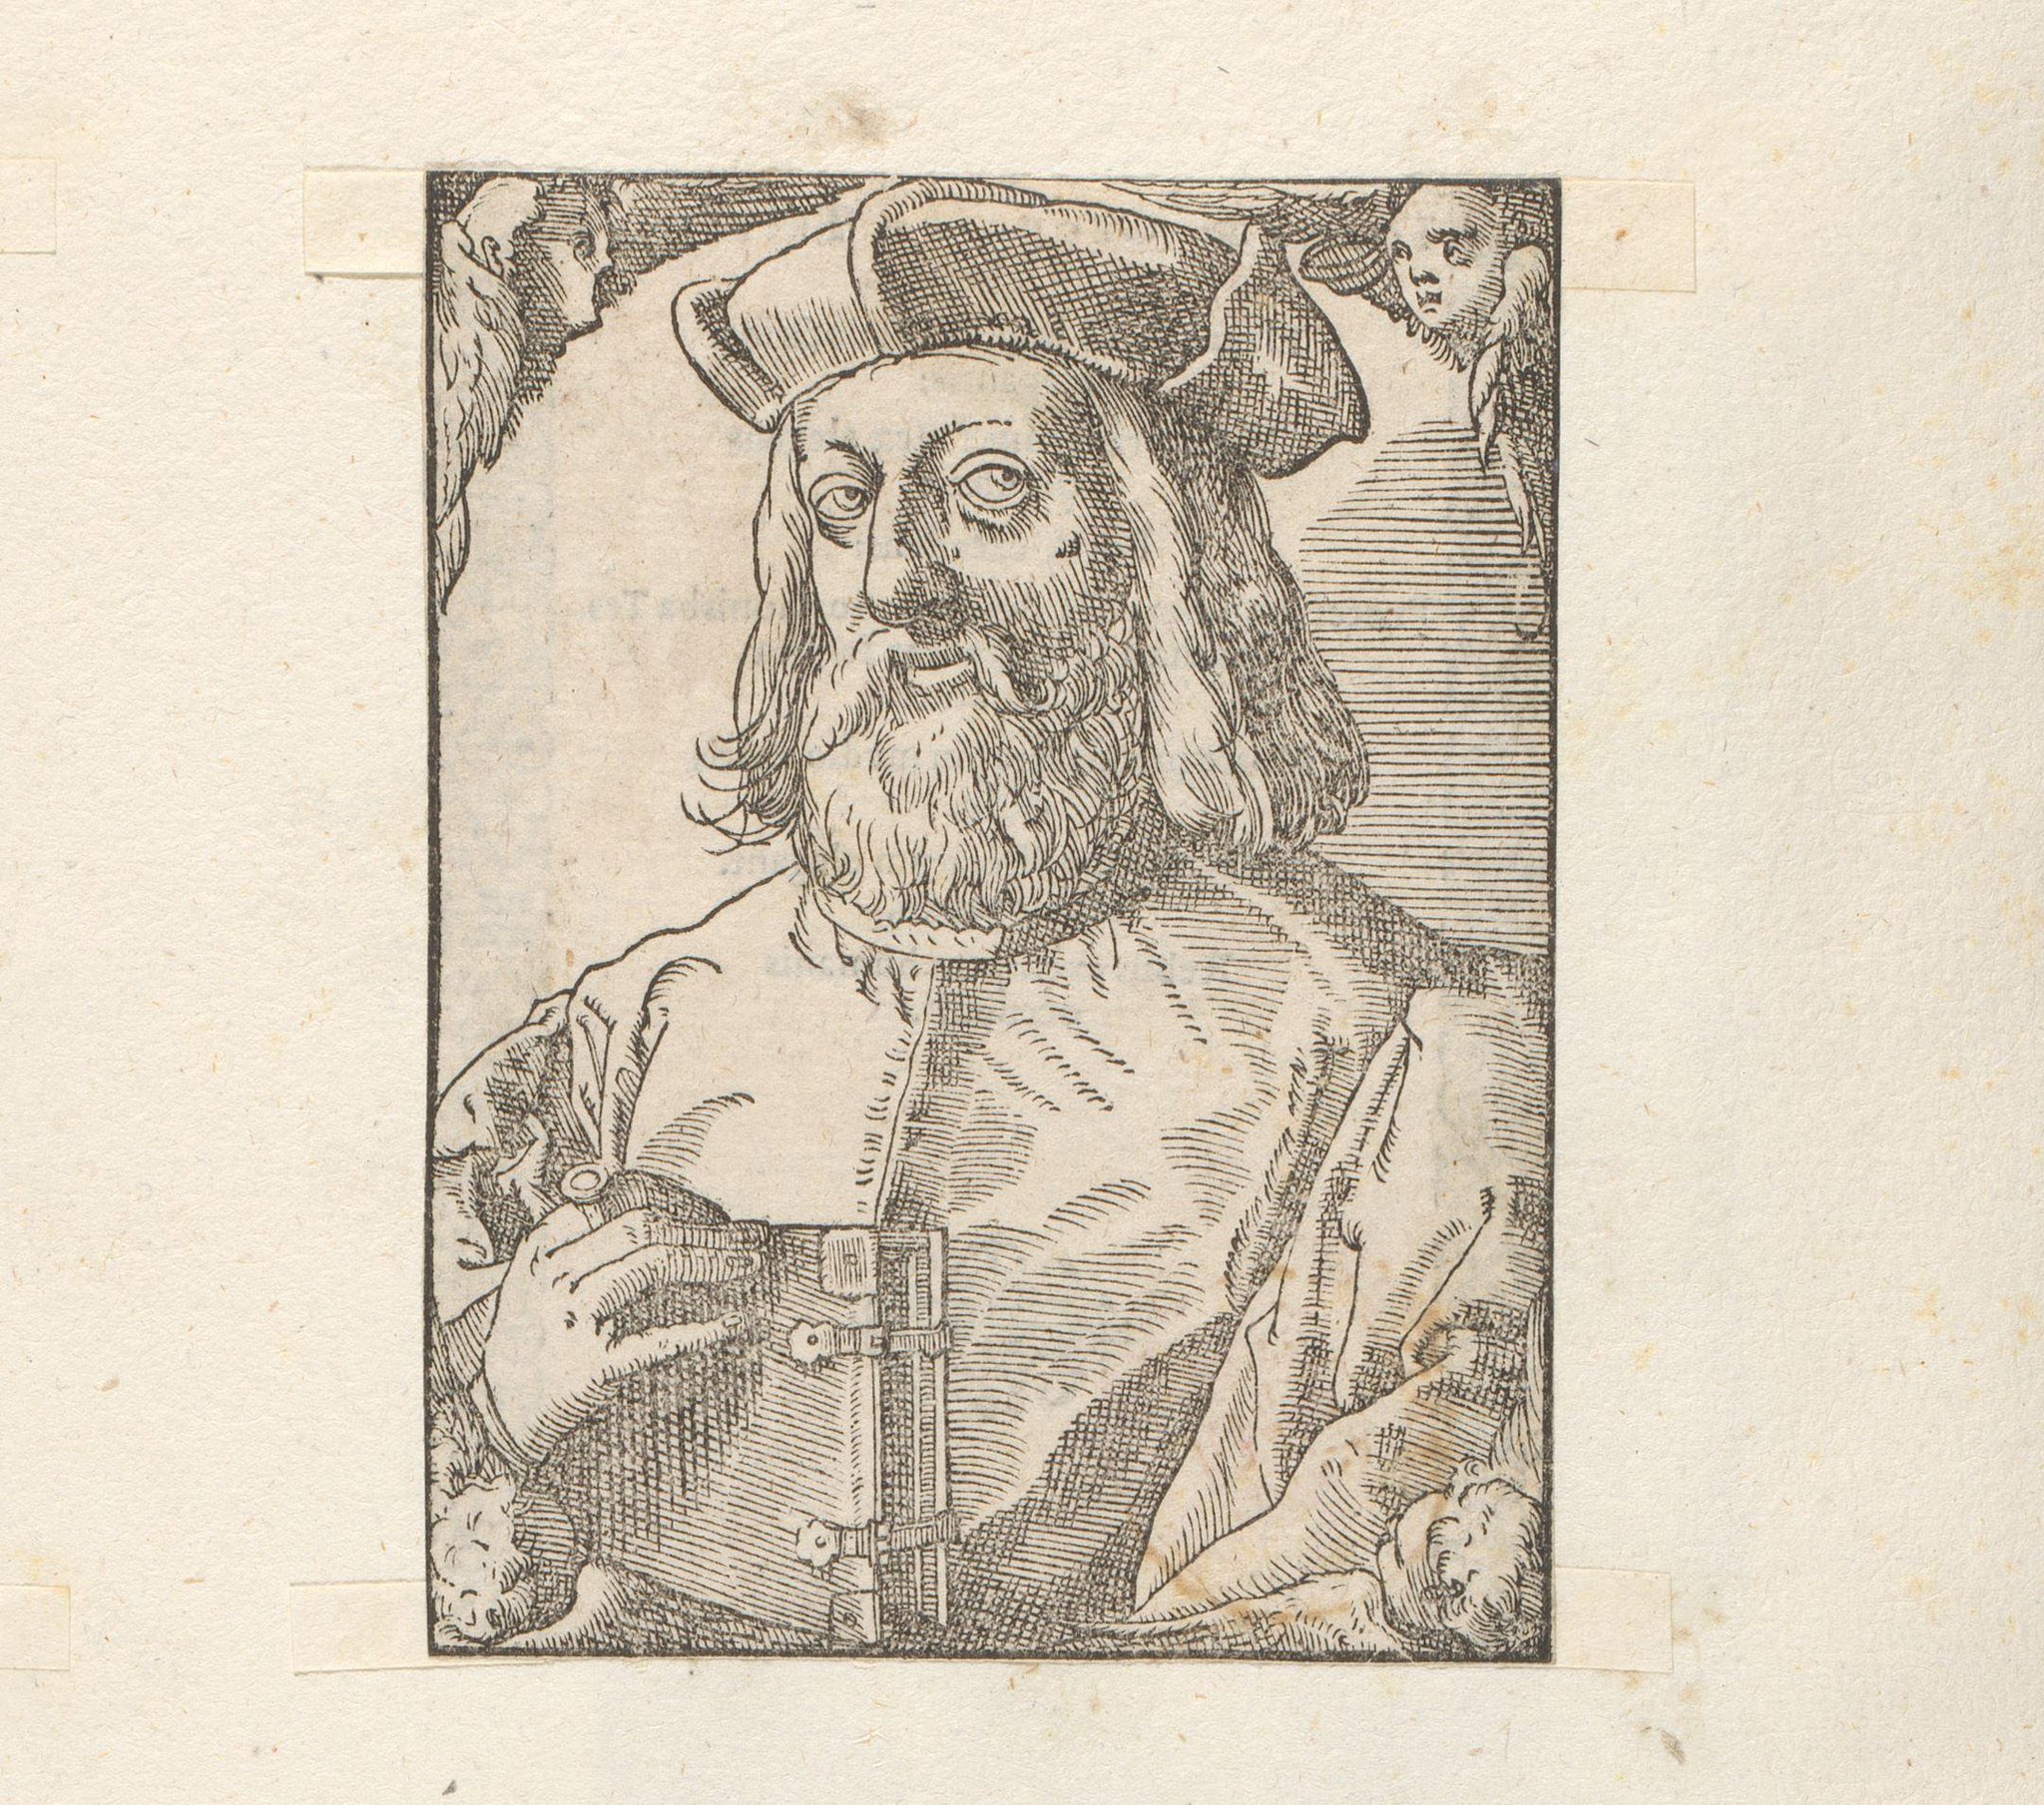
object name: book illustration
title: Portret van Gian Giorgio Trissino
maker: Anonymous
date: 1549-1584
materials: paper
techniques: letterpress printing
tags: historical persons, diplomacy, diplomat, writer, poet, author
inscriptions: collector's mark: Lugt 240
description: Prent gebruikt in: Reusner, Nikolaus. Icones Sive Imagines Vivae. Bazel: Conrad Waldkirch, 1589.